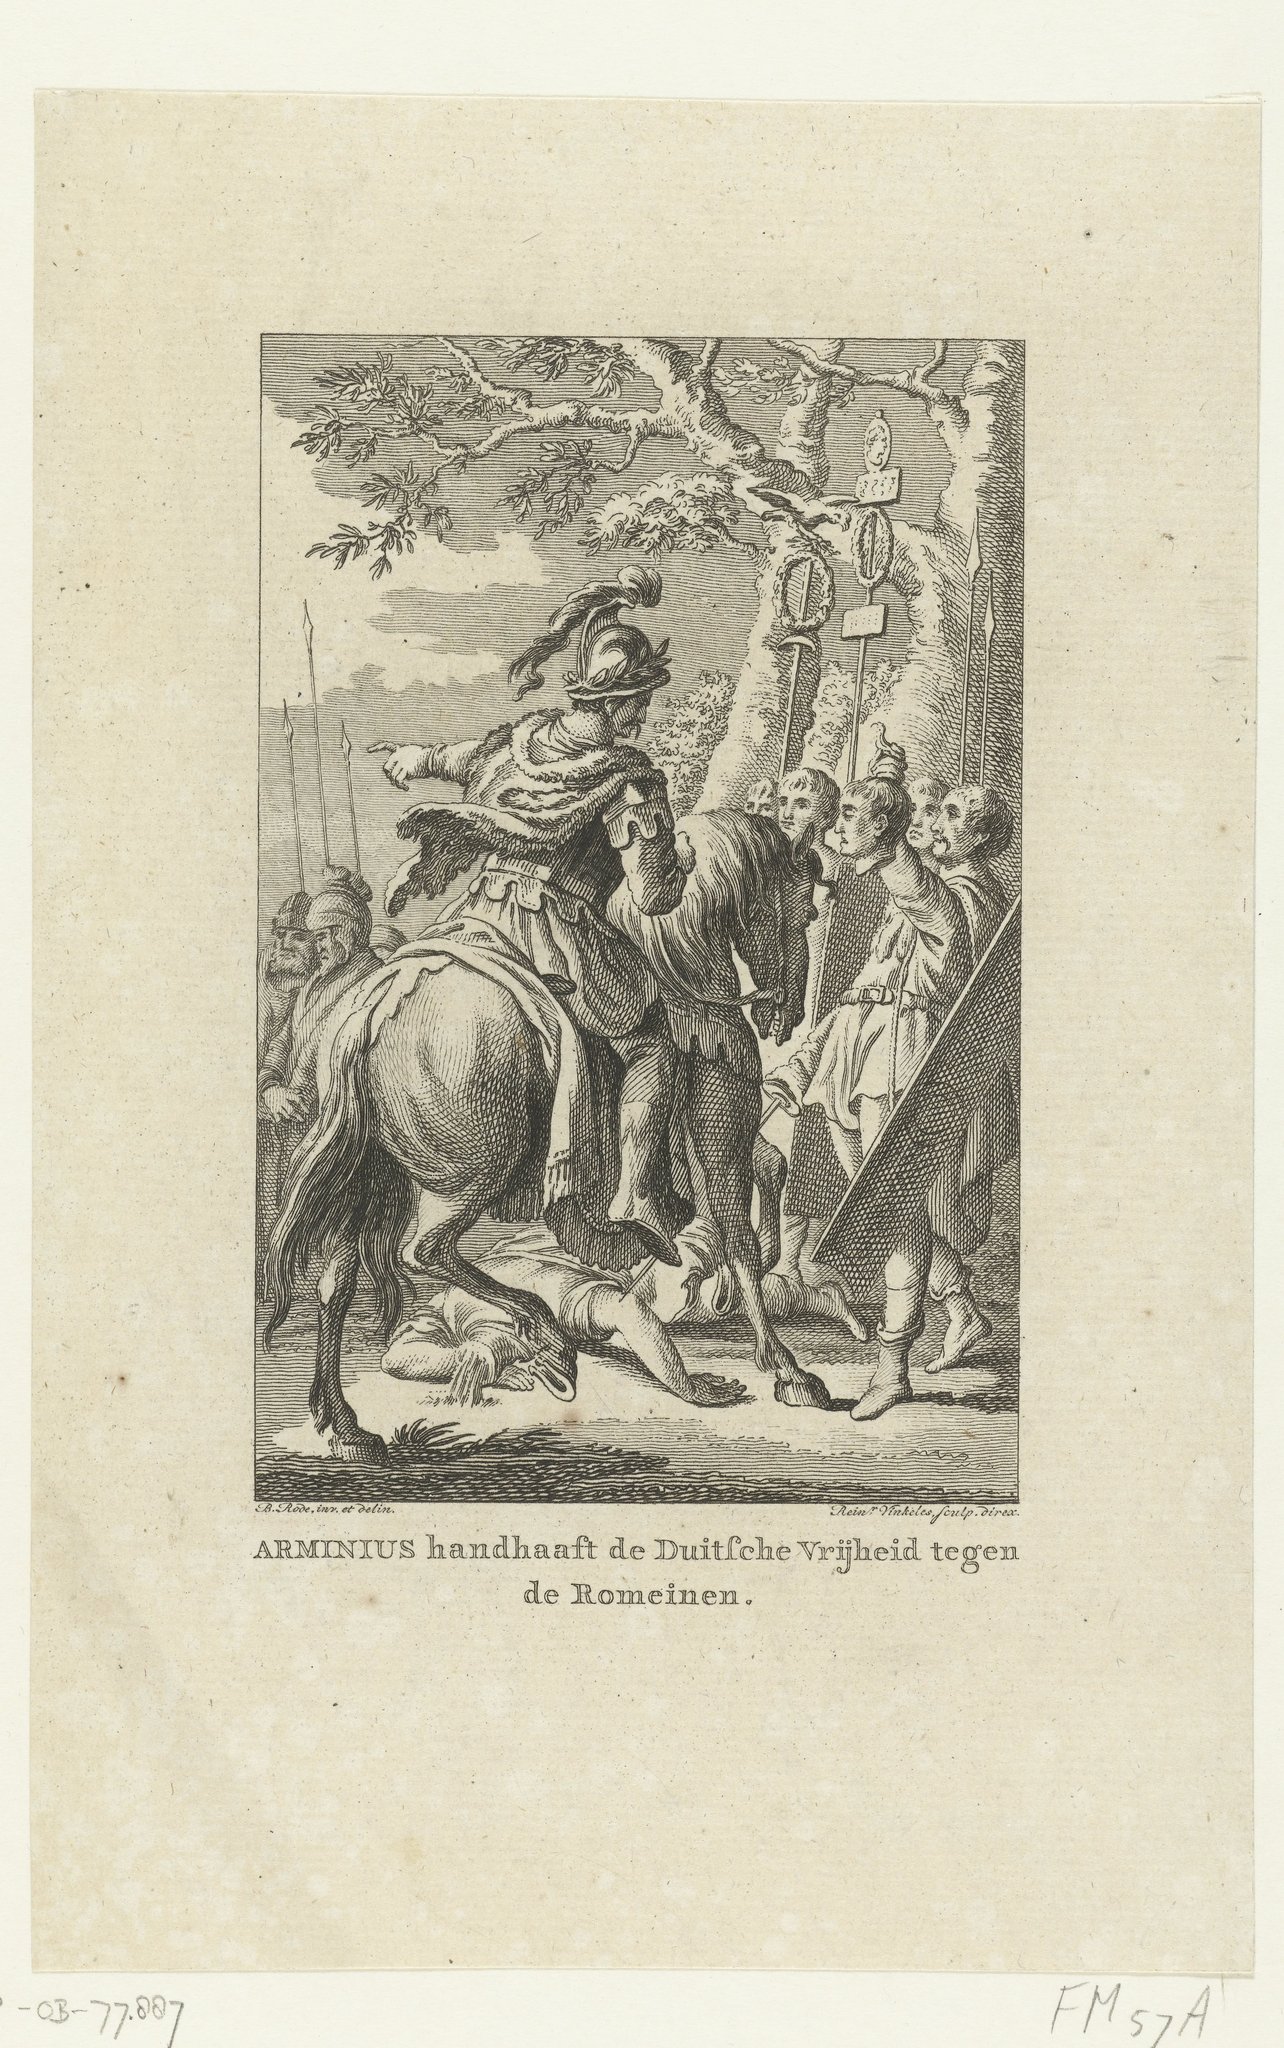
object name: history print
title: De Germaanse veldheer Arminius standvastig tegenover de Romeinen, ca. 10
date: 1751-1799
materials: paper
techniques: etching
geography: netherlands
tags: extinct, 'historical' peoples (with name), netherlands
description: Illustratie waarschijnlijk voor: Jacobus Kok, Vaderlandsch Woordenboek, Johannes Allart, Amsterdam 1785-1799. Niet in Frederik Muller; door het RPK toegevoegd nummer.